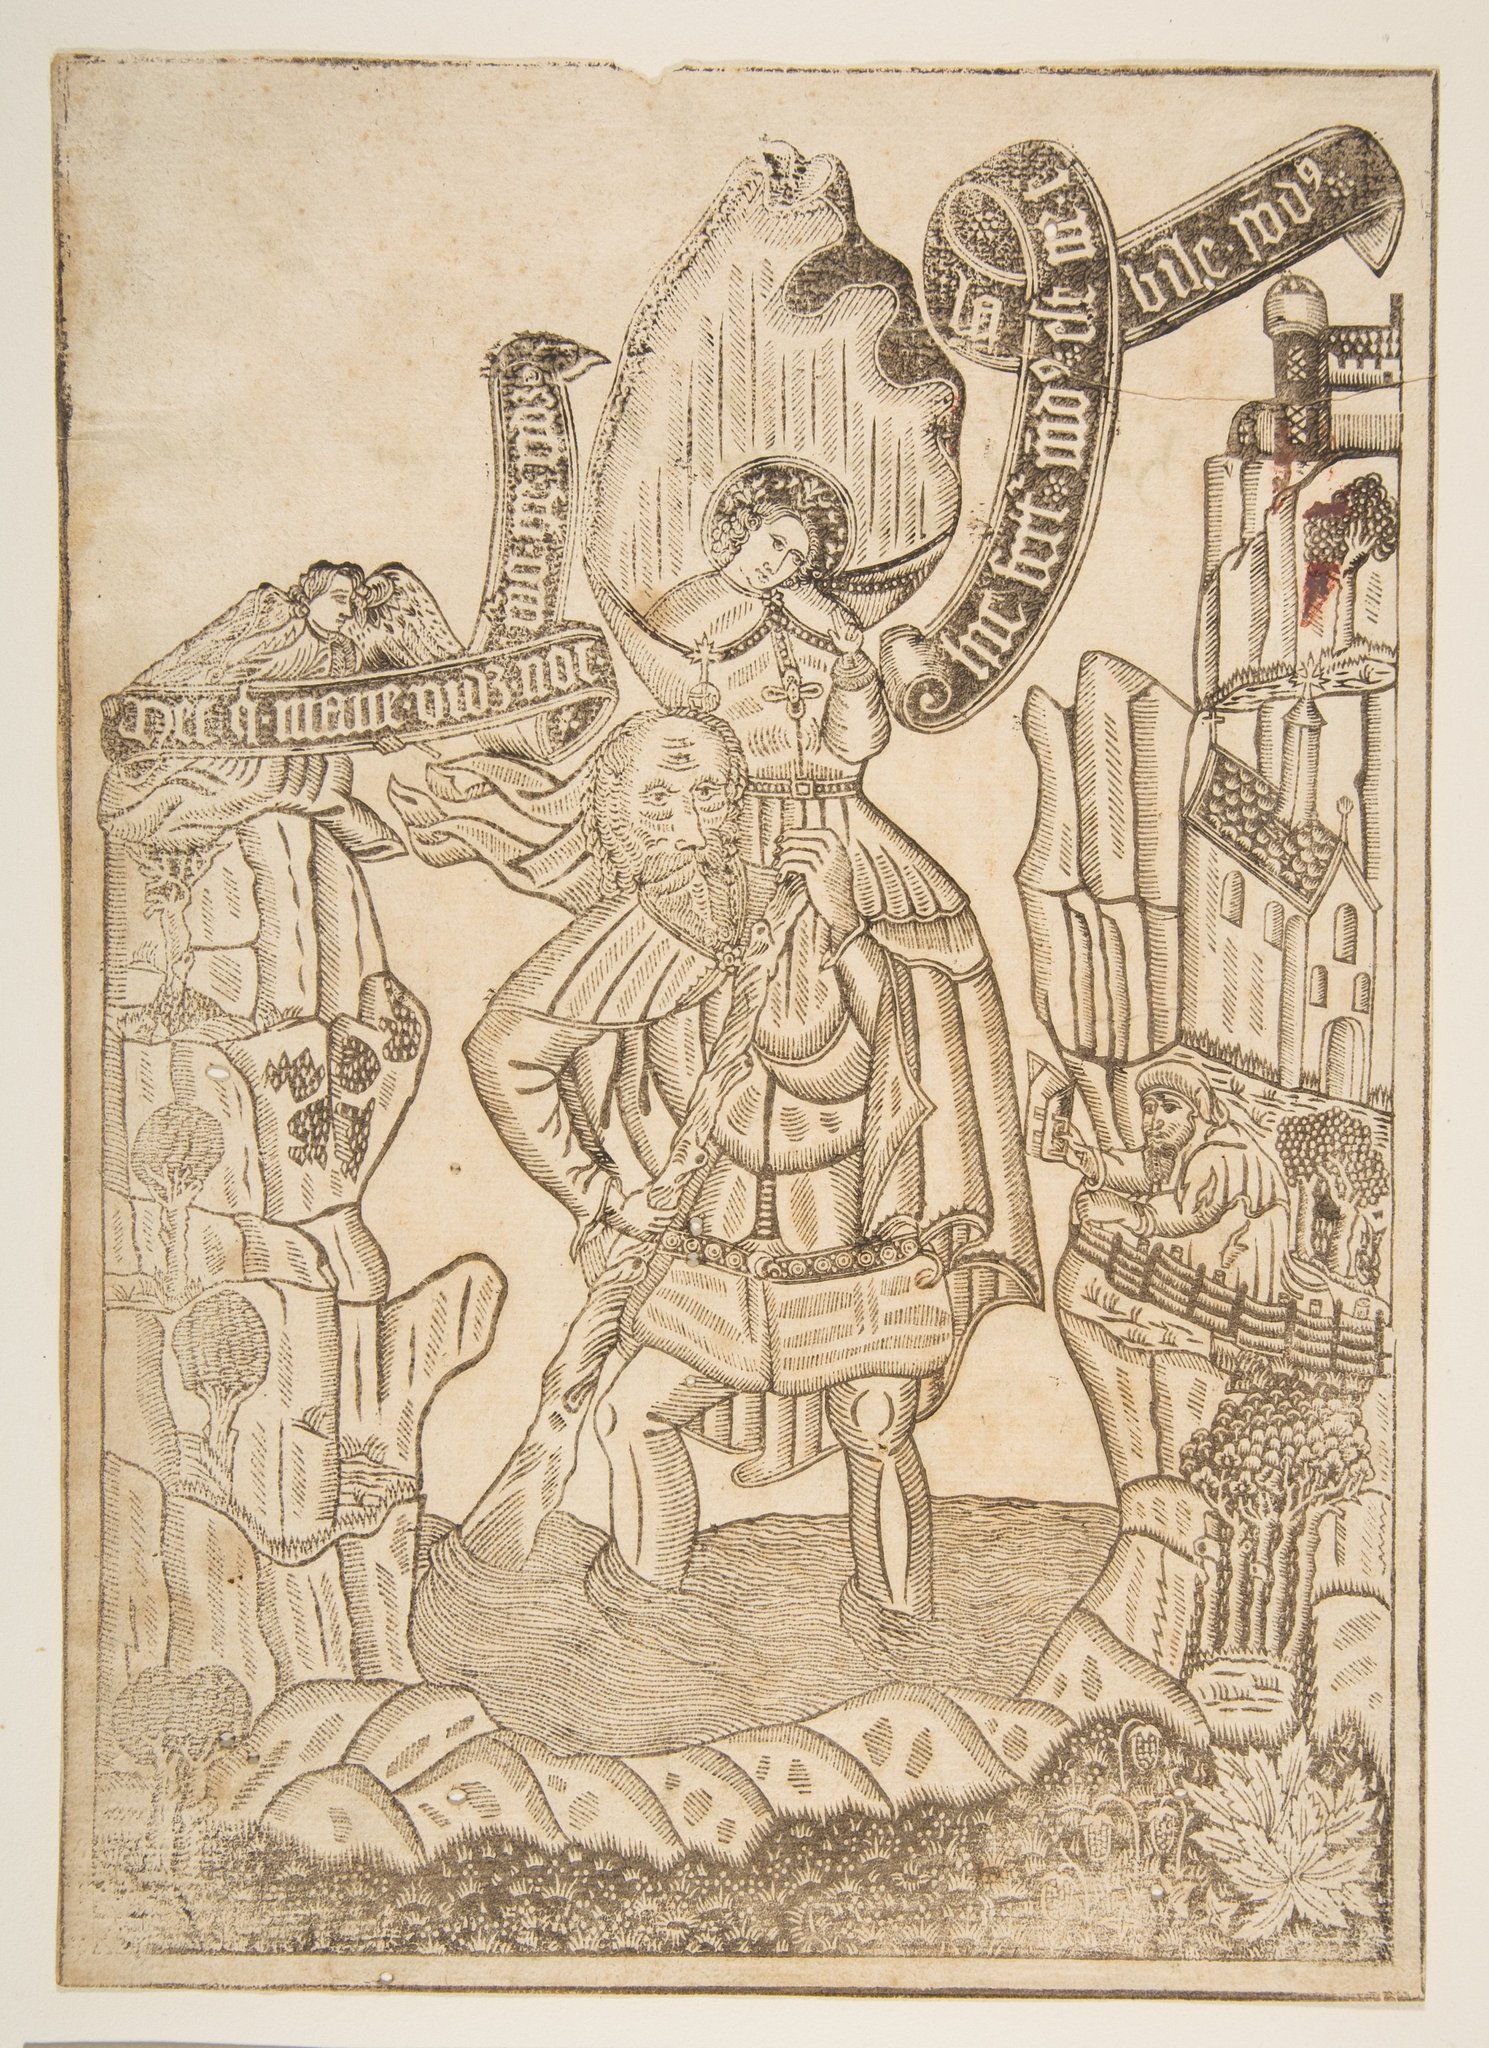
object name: print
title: Saint Christopher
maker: anonymous, german, 19th century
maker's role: artist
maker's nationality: german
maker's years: 1800-1899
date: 1501-1600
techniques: woodcut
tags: women,saint christopher